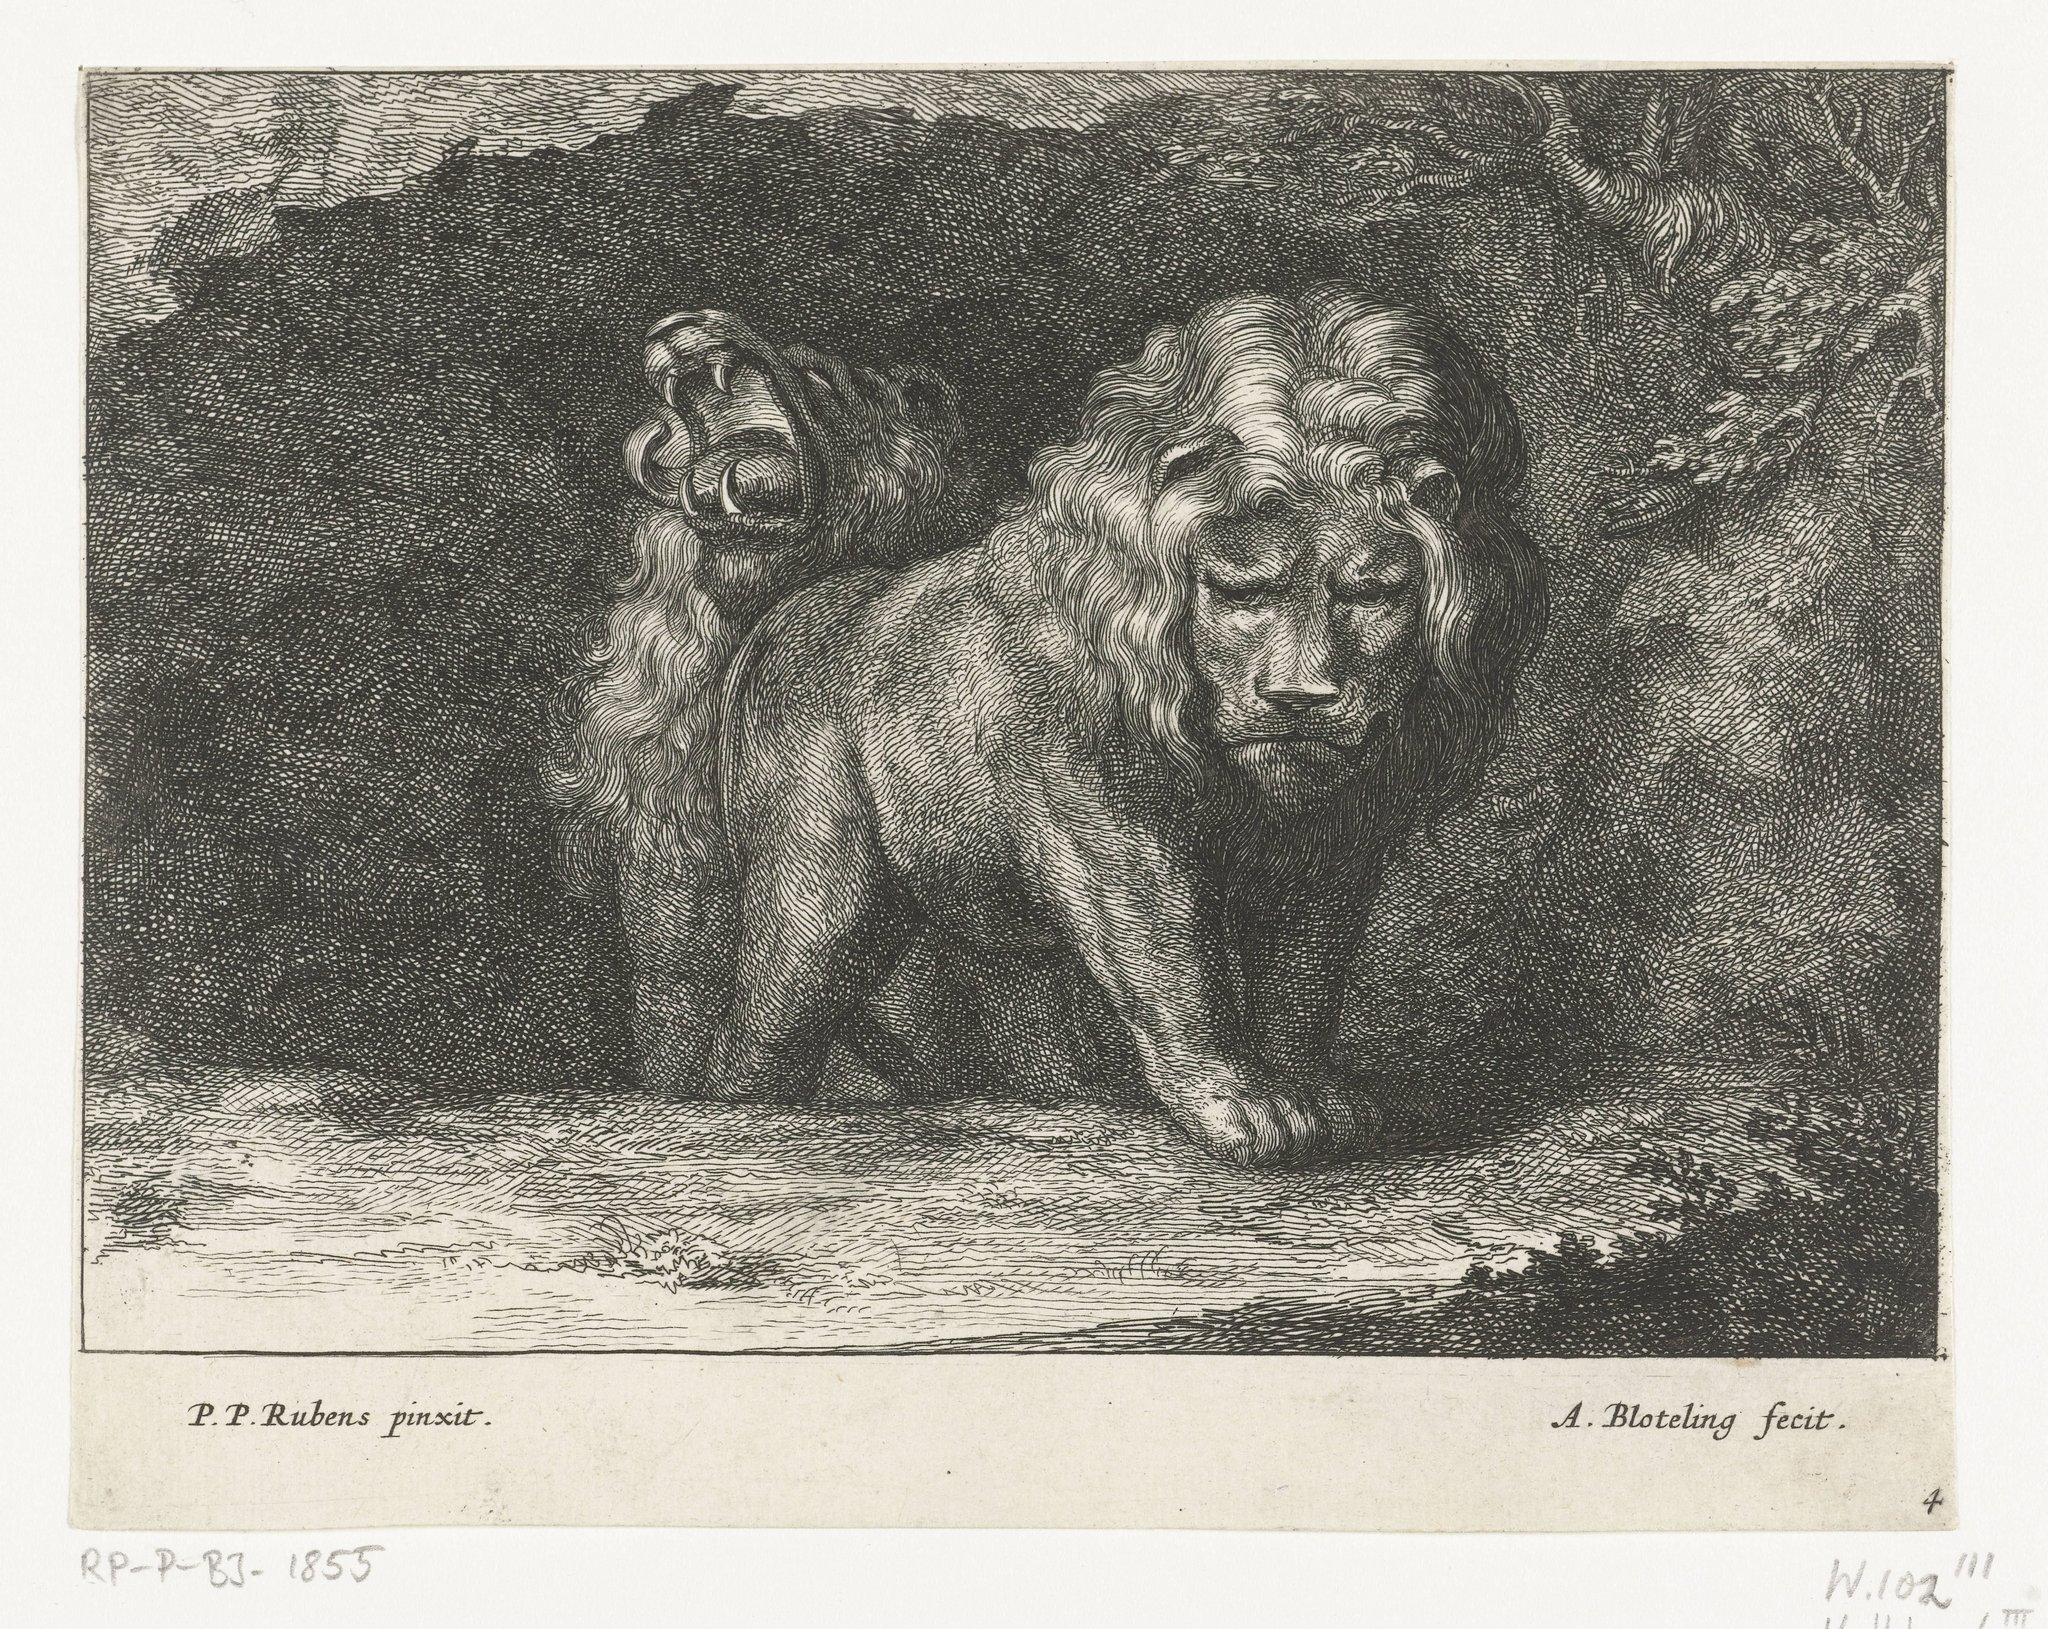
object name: print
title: Variæ leonum Icones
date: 1655-1690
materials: paper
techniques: etching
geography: amsterdam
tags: beasts of prey, predatory animals: lion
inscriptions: collector's mark: Lugt 240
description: Prent uit een serie van vier prenten met voorstellingen van leeuwen naar Pieter Paul Rubens.